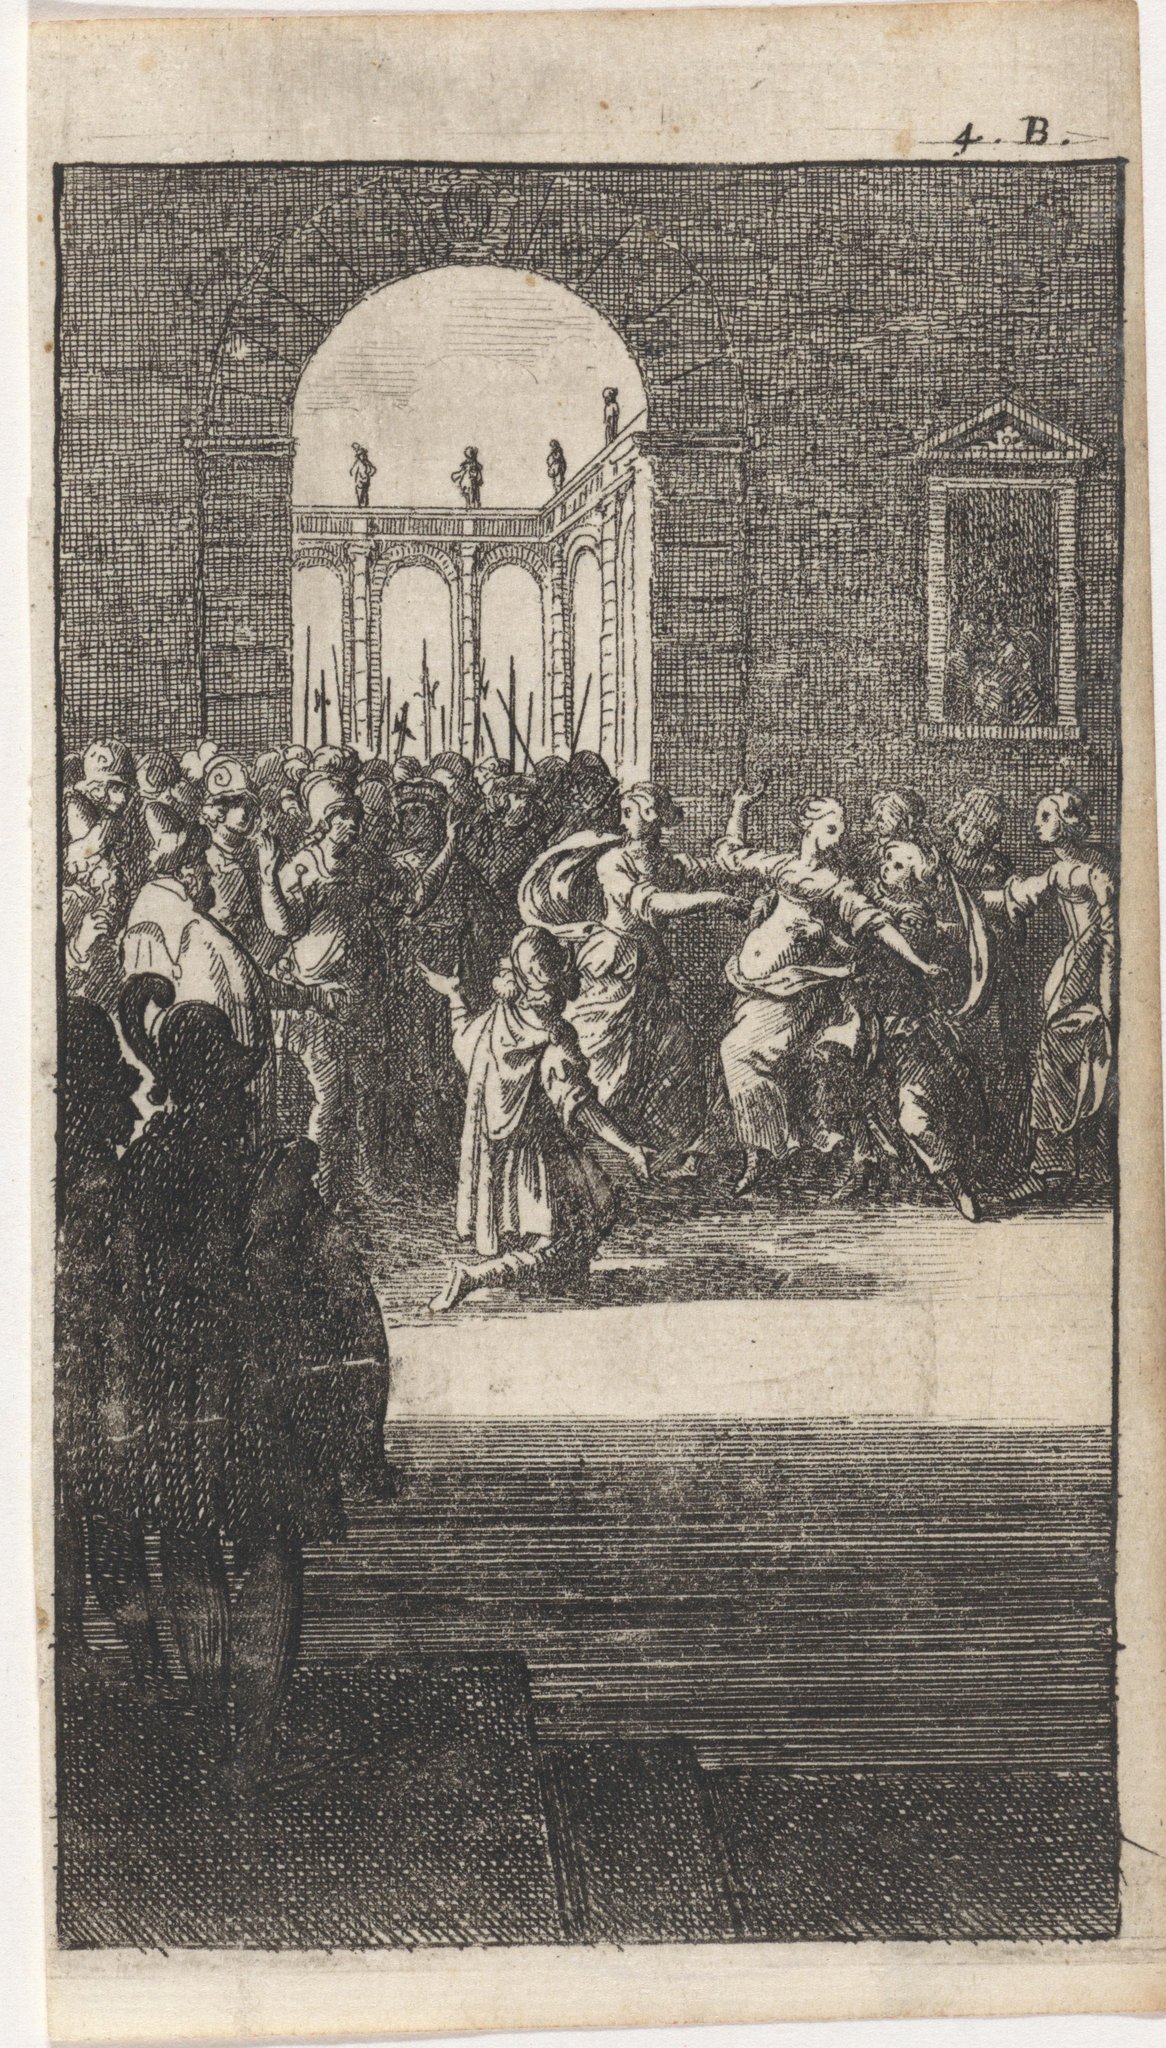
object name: book illustration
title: Soldaat knielt voor een vrouw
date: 1666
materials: paper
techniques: etching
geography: amsterdam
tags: adult woman, fainting, swooning, private soldier, kneeling figure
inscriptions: collector's mark: Lugt 2228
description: In een grote ruimte knielt een soldaat voor een vrouw, die lijkt flauw te vallen. Andere vrouwen kijken snellen verschrikt toe. Achter de geknielde soldaat staat een leger. Rechtsboven: 4. B.